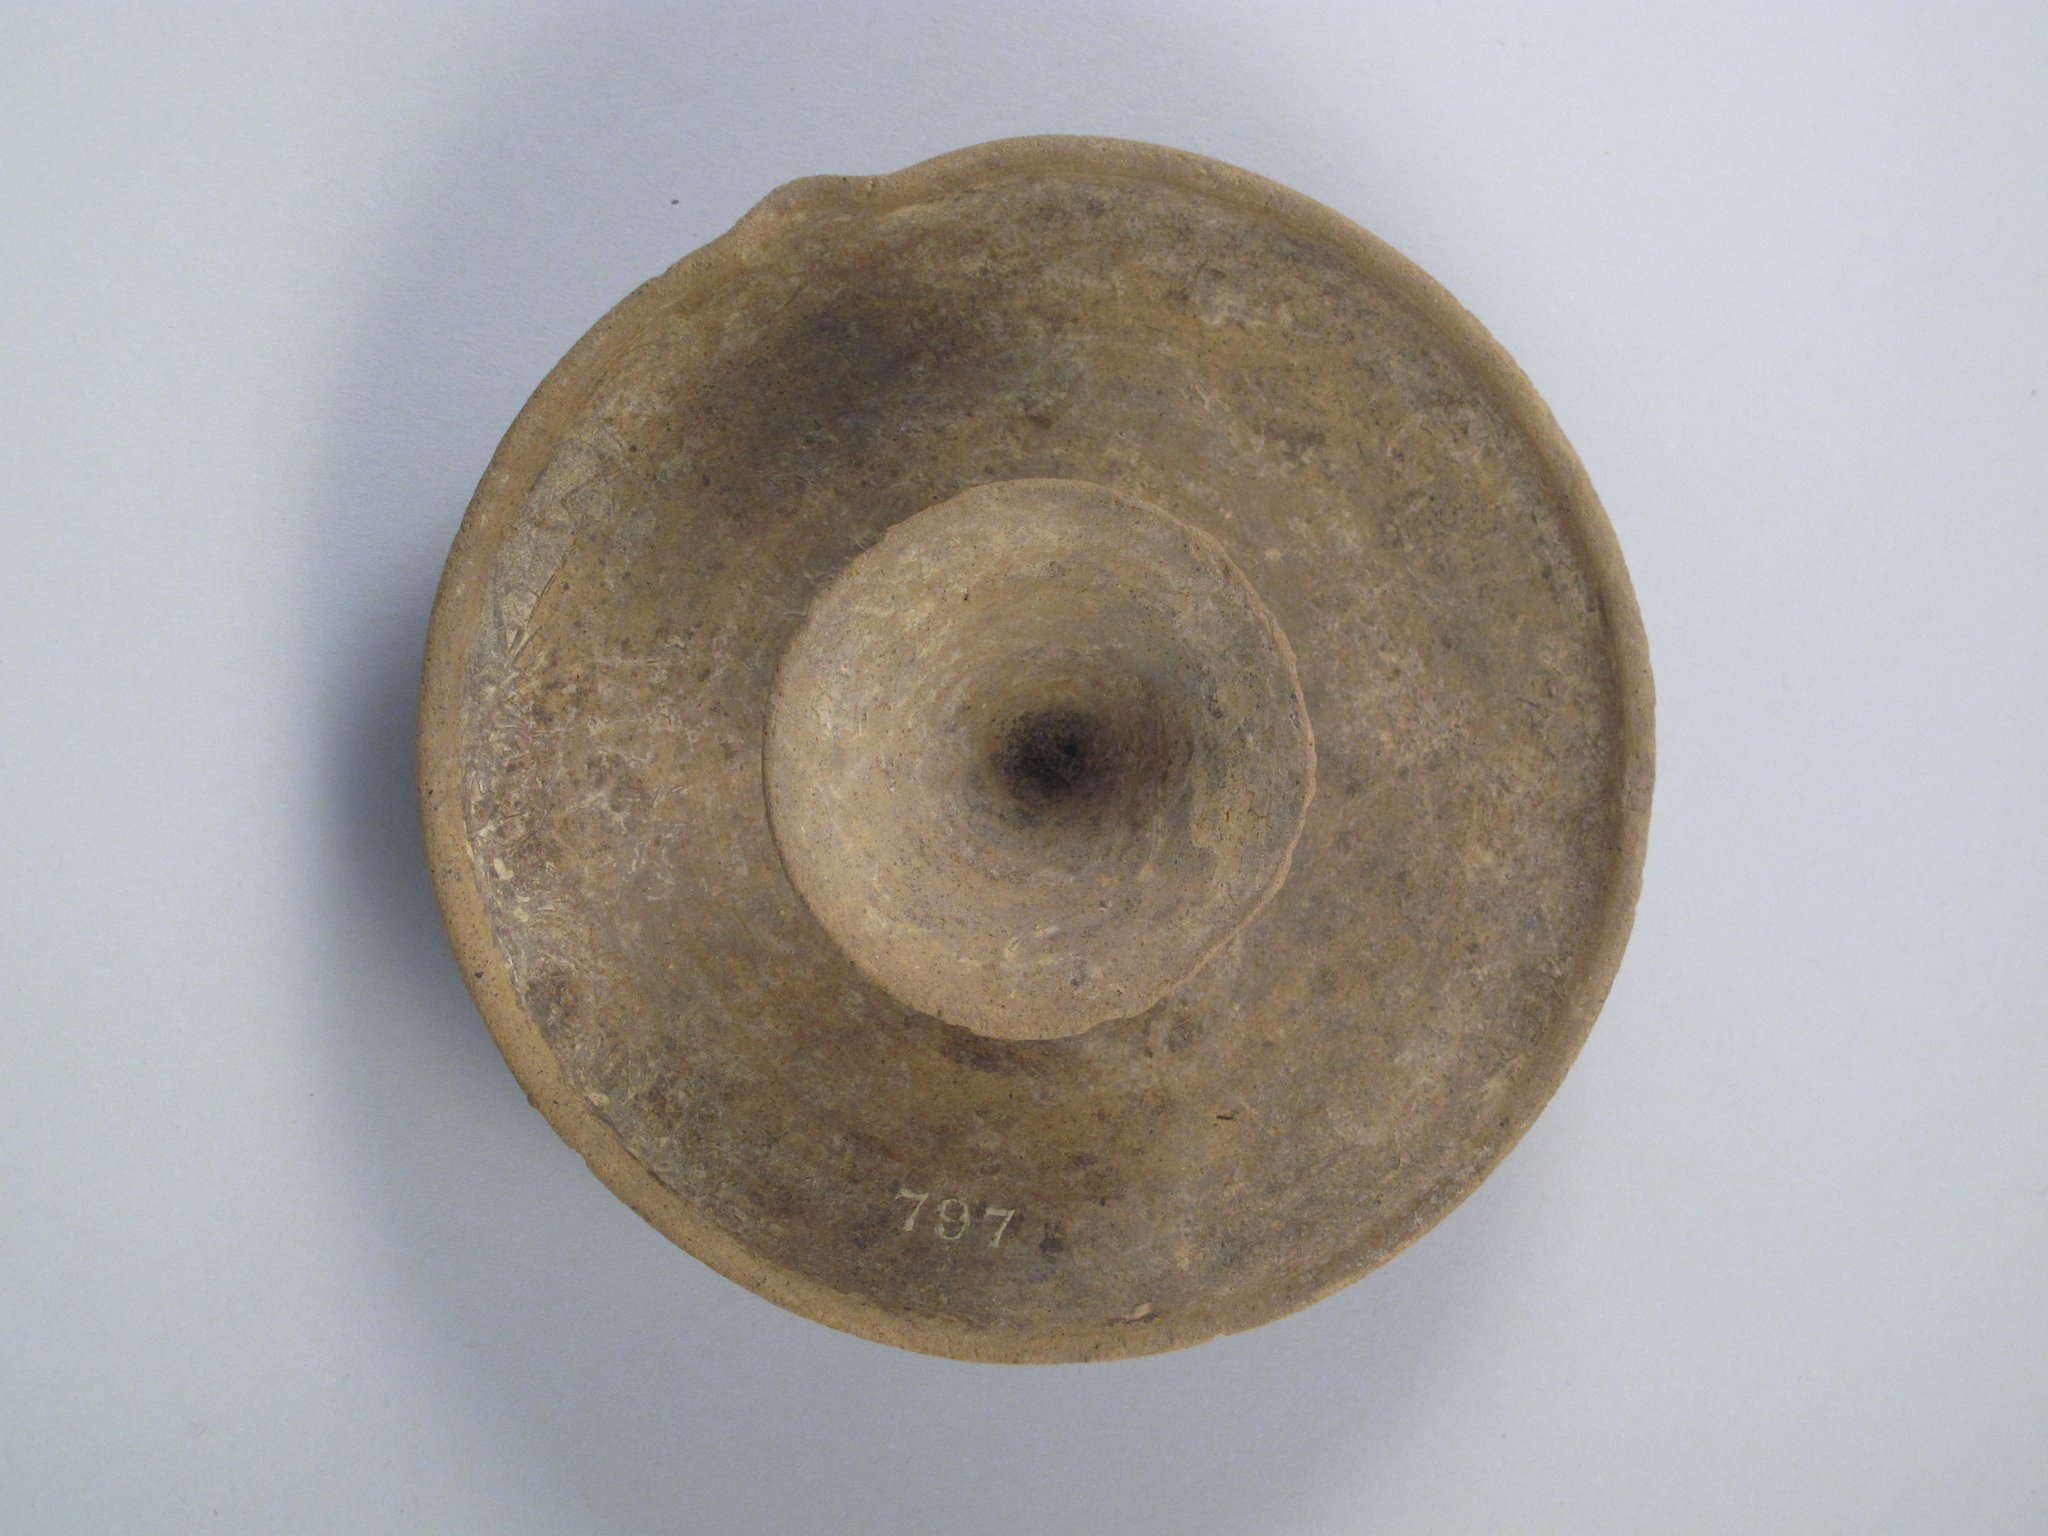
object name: torch holder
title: Torch-holder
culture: cypriot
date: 600-301 BCE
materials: terracotta